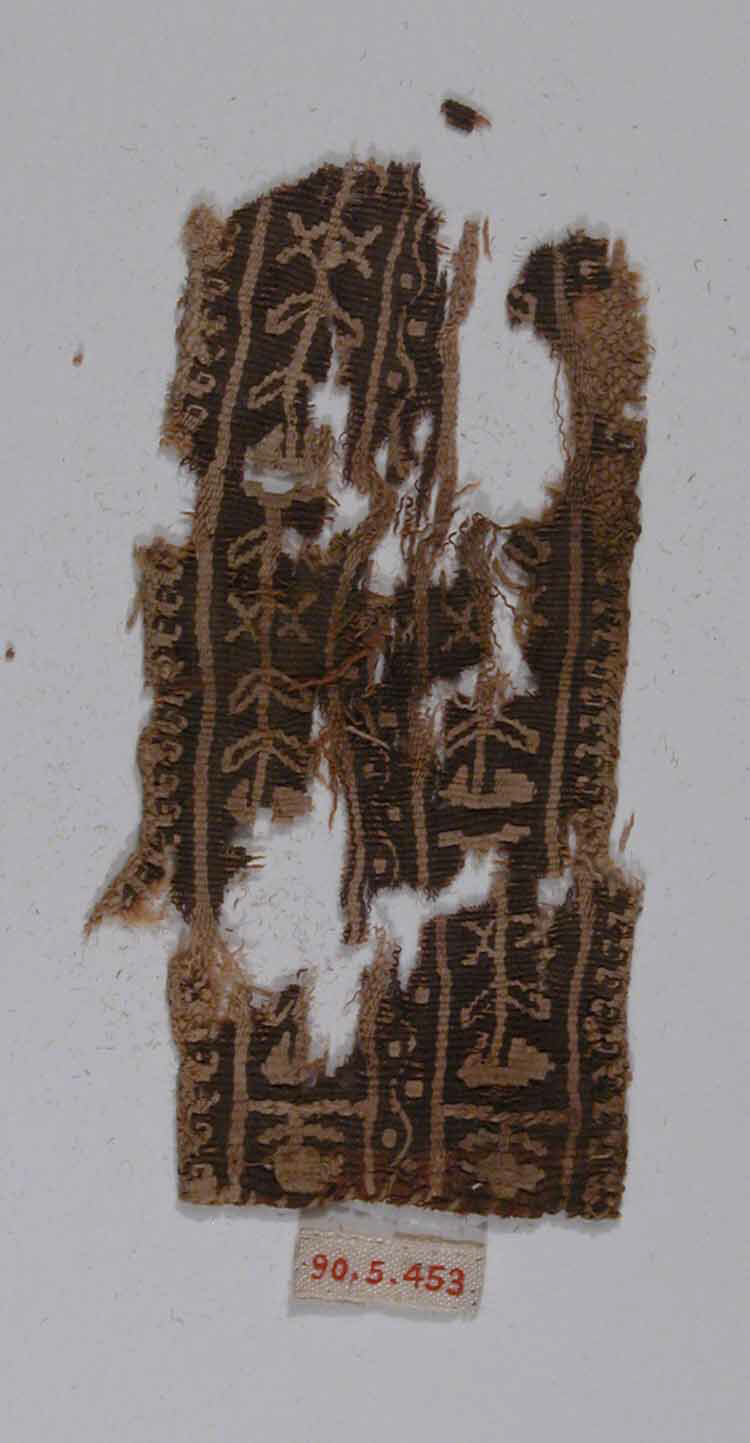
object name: textile fragment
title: Fragment of a Sleeve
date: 401-500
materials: linen, wool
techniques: weave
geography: egypt